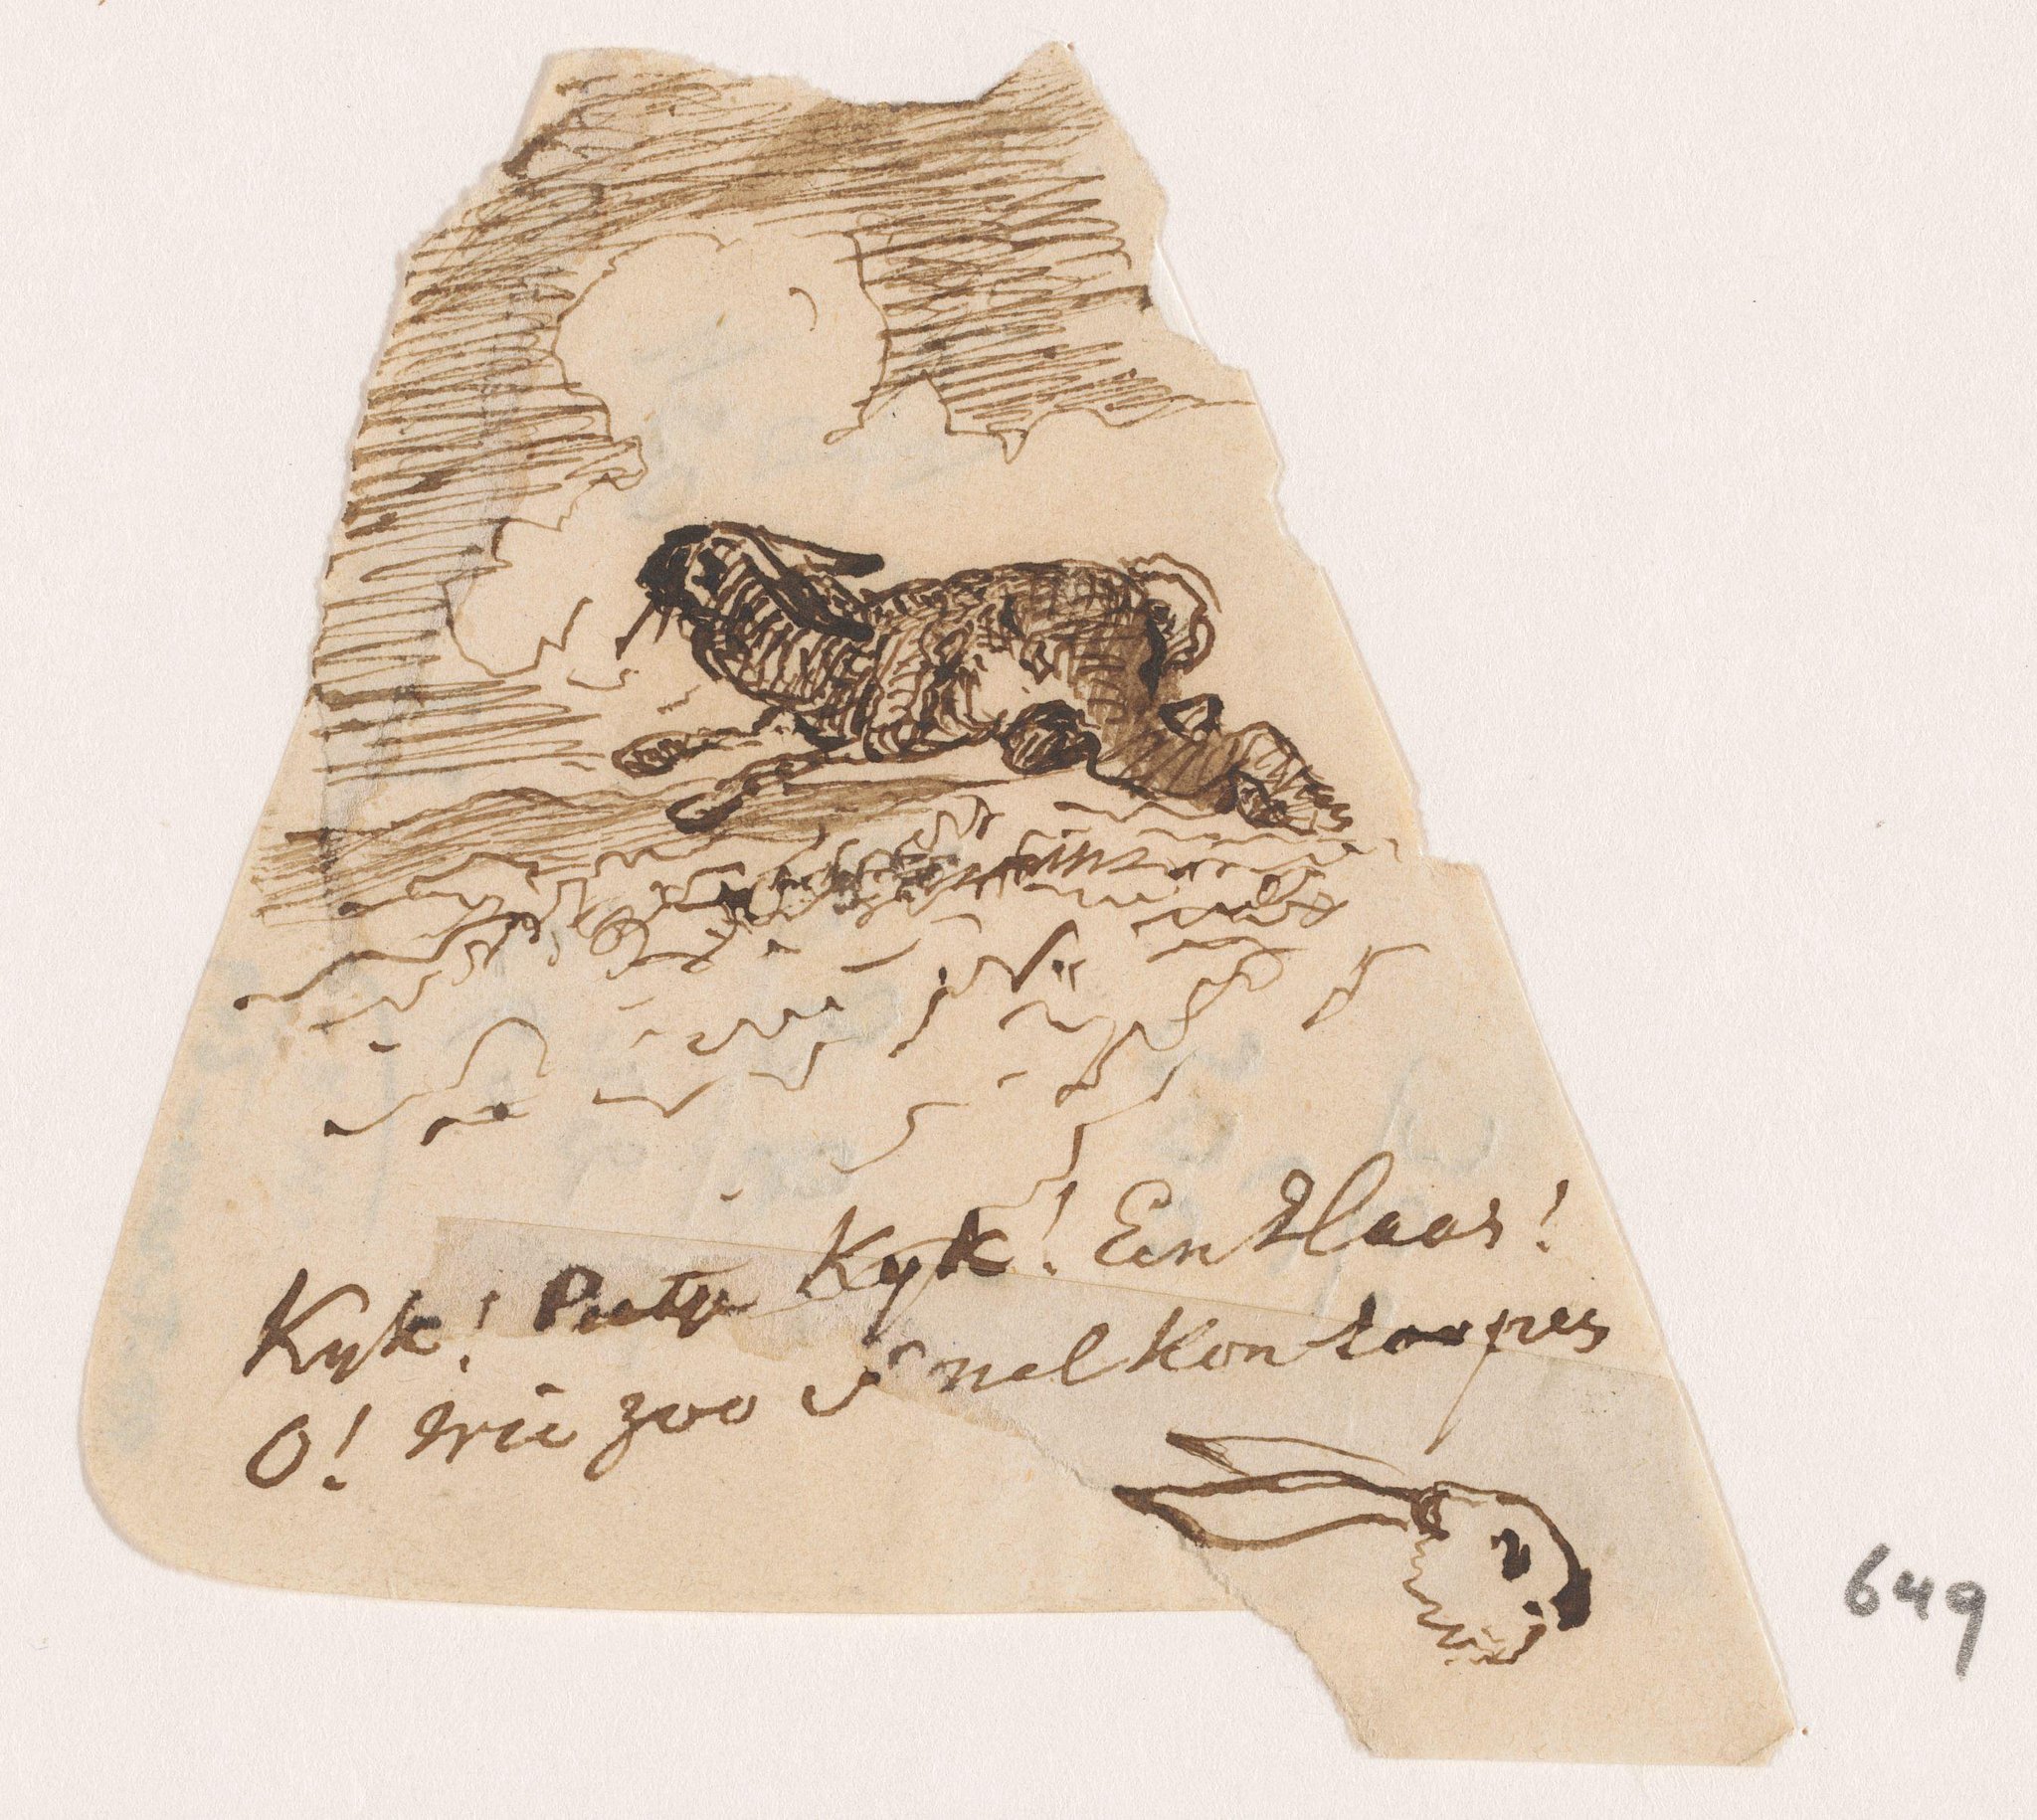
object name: drawing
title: Haas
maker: johannes tavenraat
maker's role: draughtsman, painter, print maker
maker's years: 1809-1881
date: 1840-1880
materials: ink, paper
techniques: pen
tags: rodents: hare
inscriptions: collector's mark: Lugt 2228, annotation: ‘Kijk! Pietje kijk! ...’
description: Haas. Getekend op een fragment van een envelop.